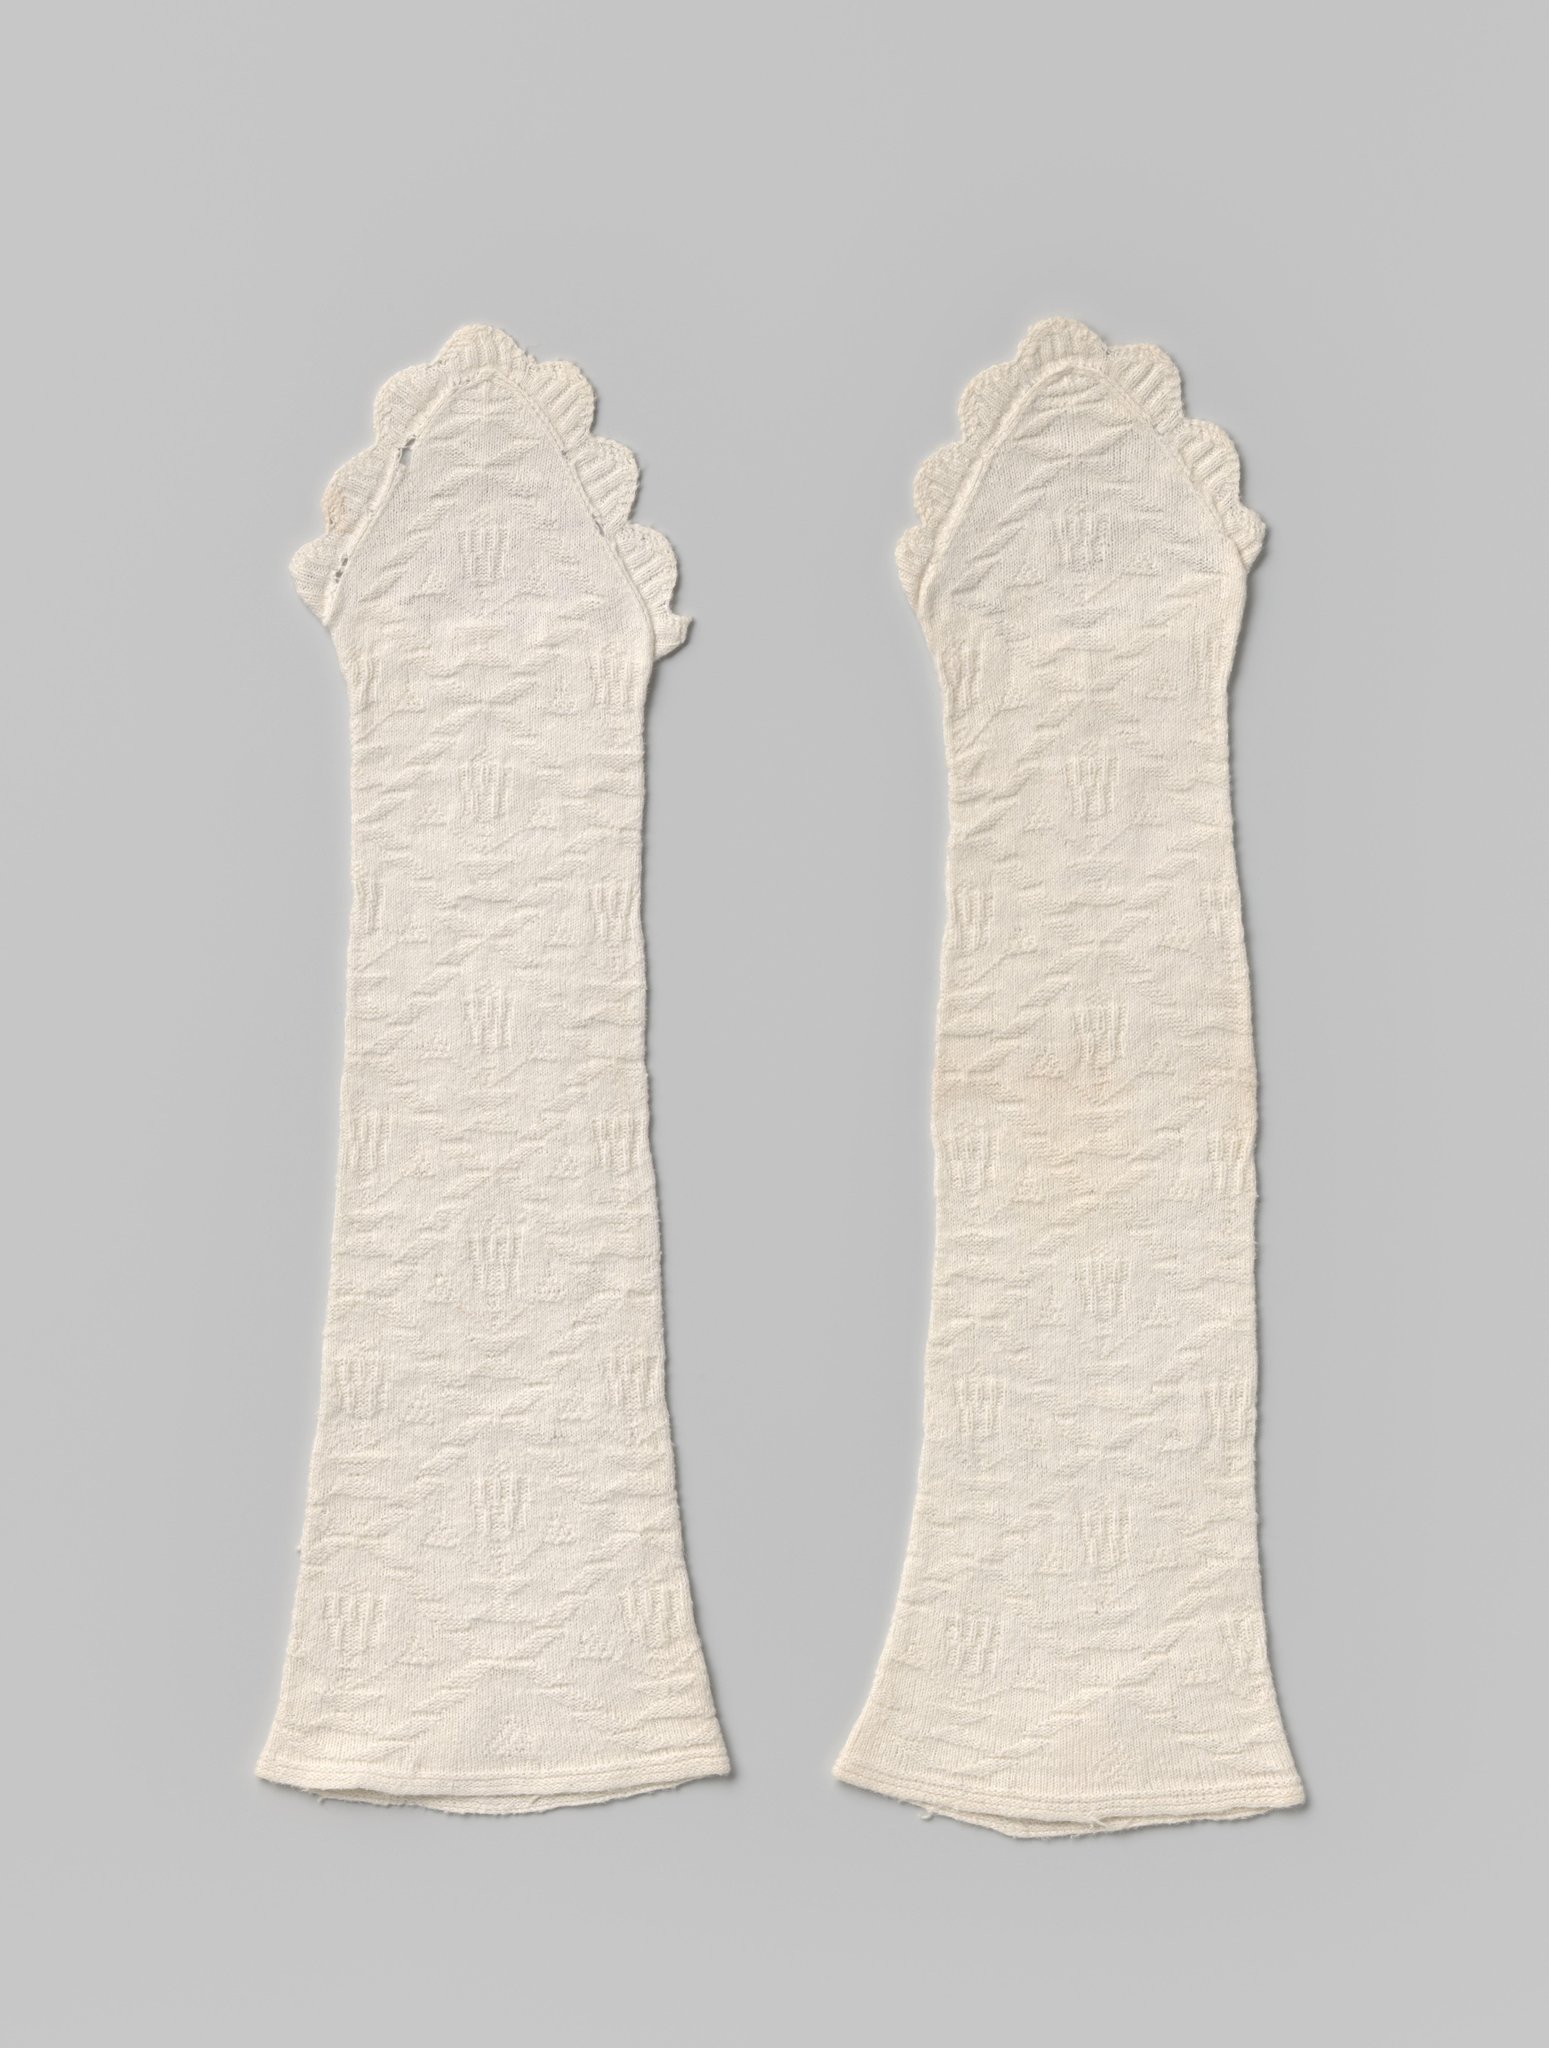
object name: clothing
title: Mitaine van witte gebreide katoen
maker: Anonymous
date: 1700-1750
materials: cotton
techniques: knitting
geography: netherlands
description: Mitaines van gebreid wit katoen, met gelijk ingebreid patroon van rasterwerk met grote bloem; het éne gemerkt ivm (of mm?), het andere met I. Model: Ellebooglang. Zonder duimen met driehoekig gedeelte dat over de handrug valt. Hieraan is een rand van schulpen aangebreid. Er is één lengtenaad. Breipatroon: Rasterwerk, dat gevormd is van schuin boven elkaar staande dropjes, is telkens gevuld, met een diabolo-vormige vaas, waarin een grote tulp aan korte steel staat, tussen twee blaadjes. De merken zijn in wit in een maasteek opgeborduurd.